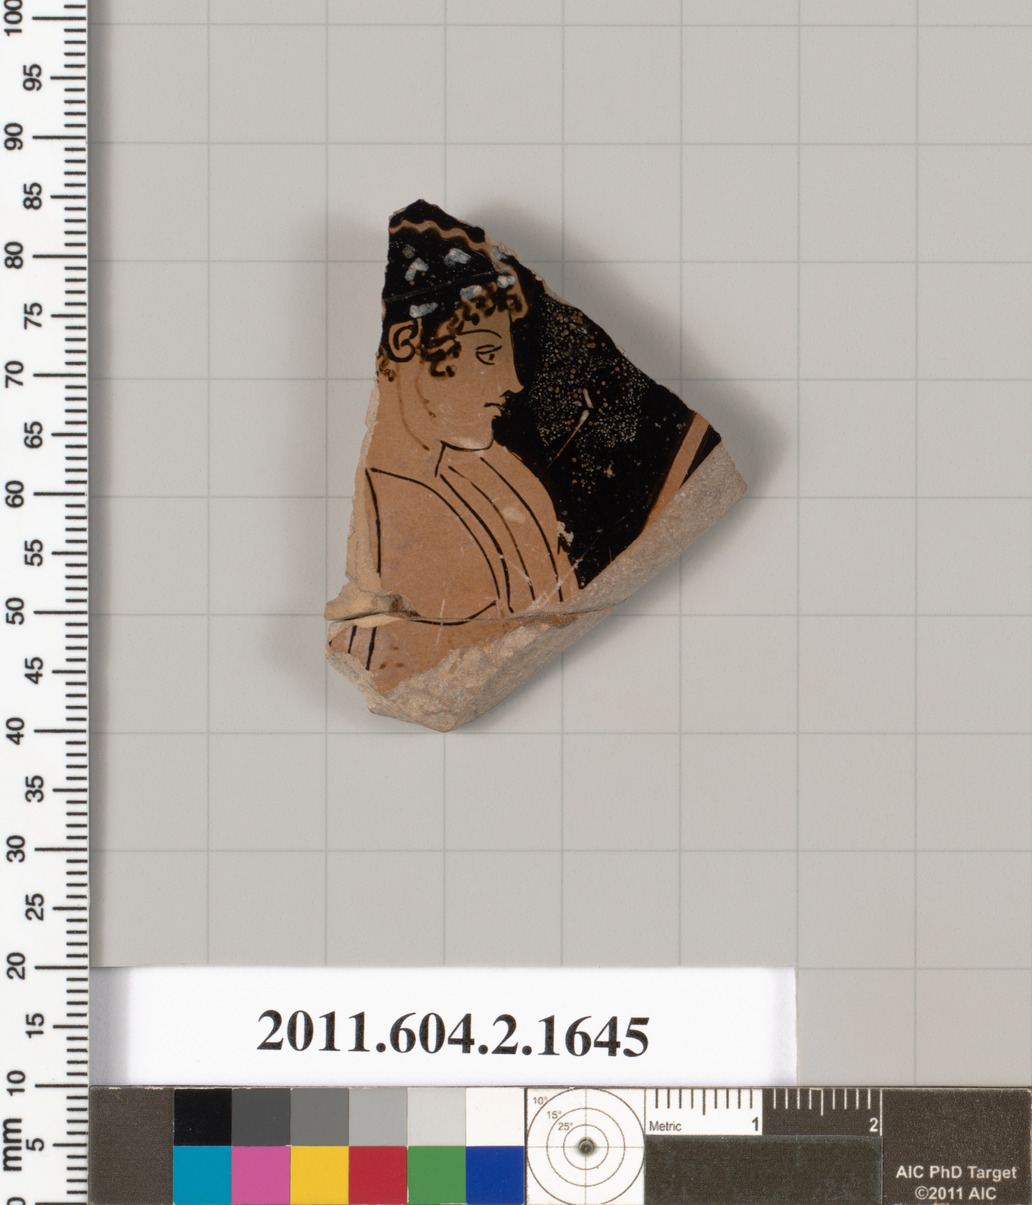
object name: skyphos fragment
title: Terracotta fragment of a skyphos (deep drinking cup)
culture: greek, attic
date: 470-460 BCE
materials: terracotta